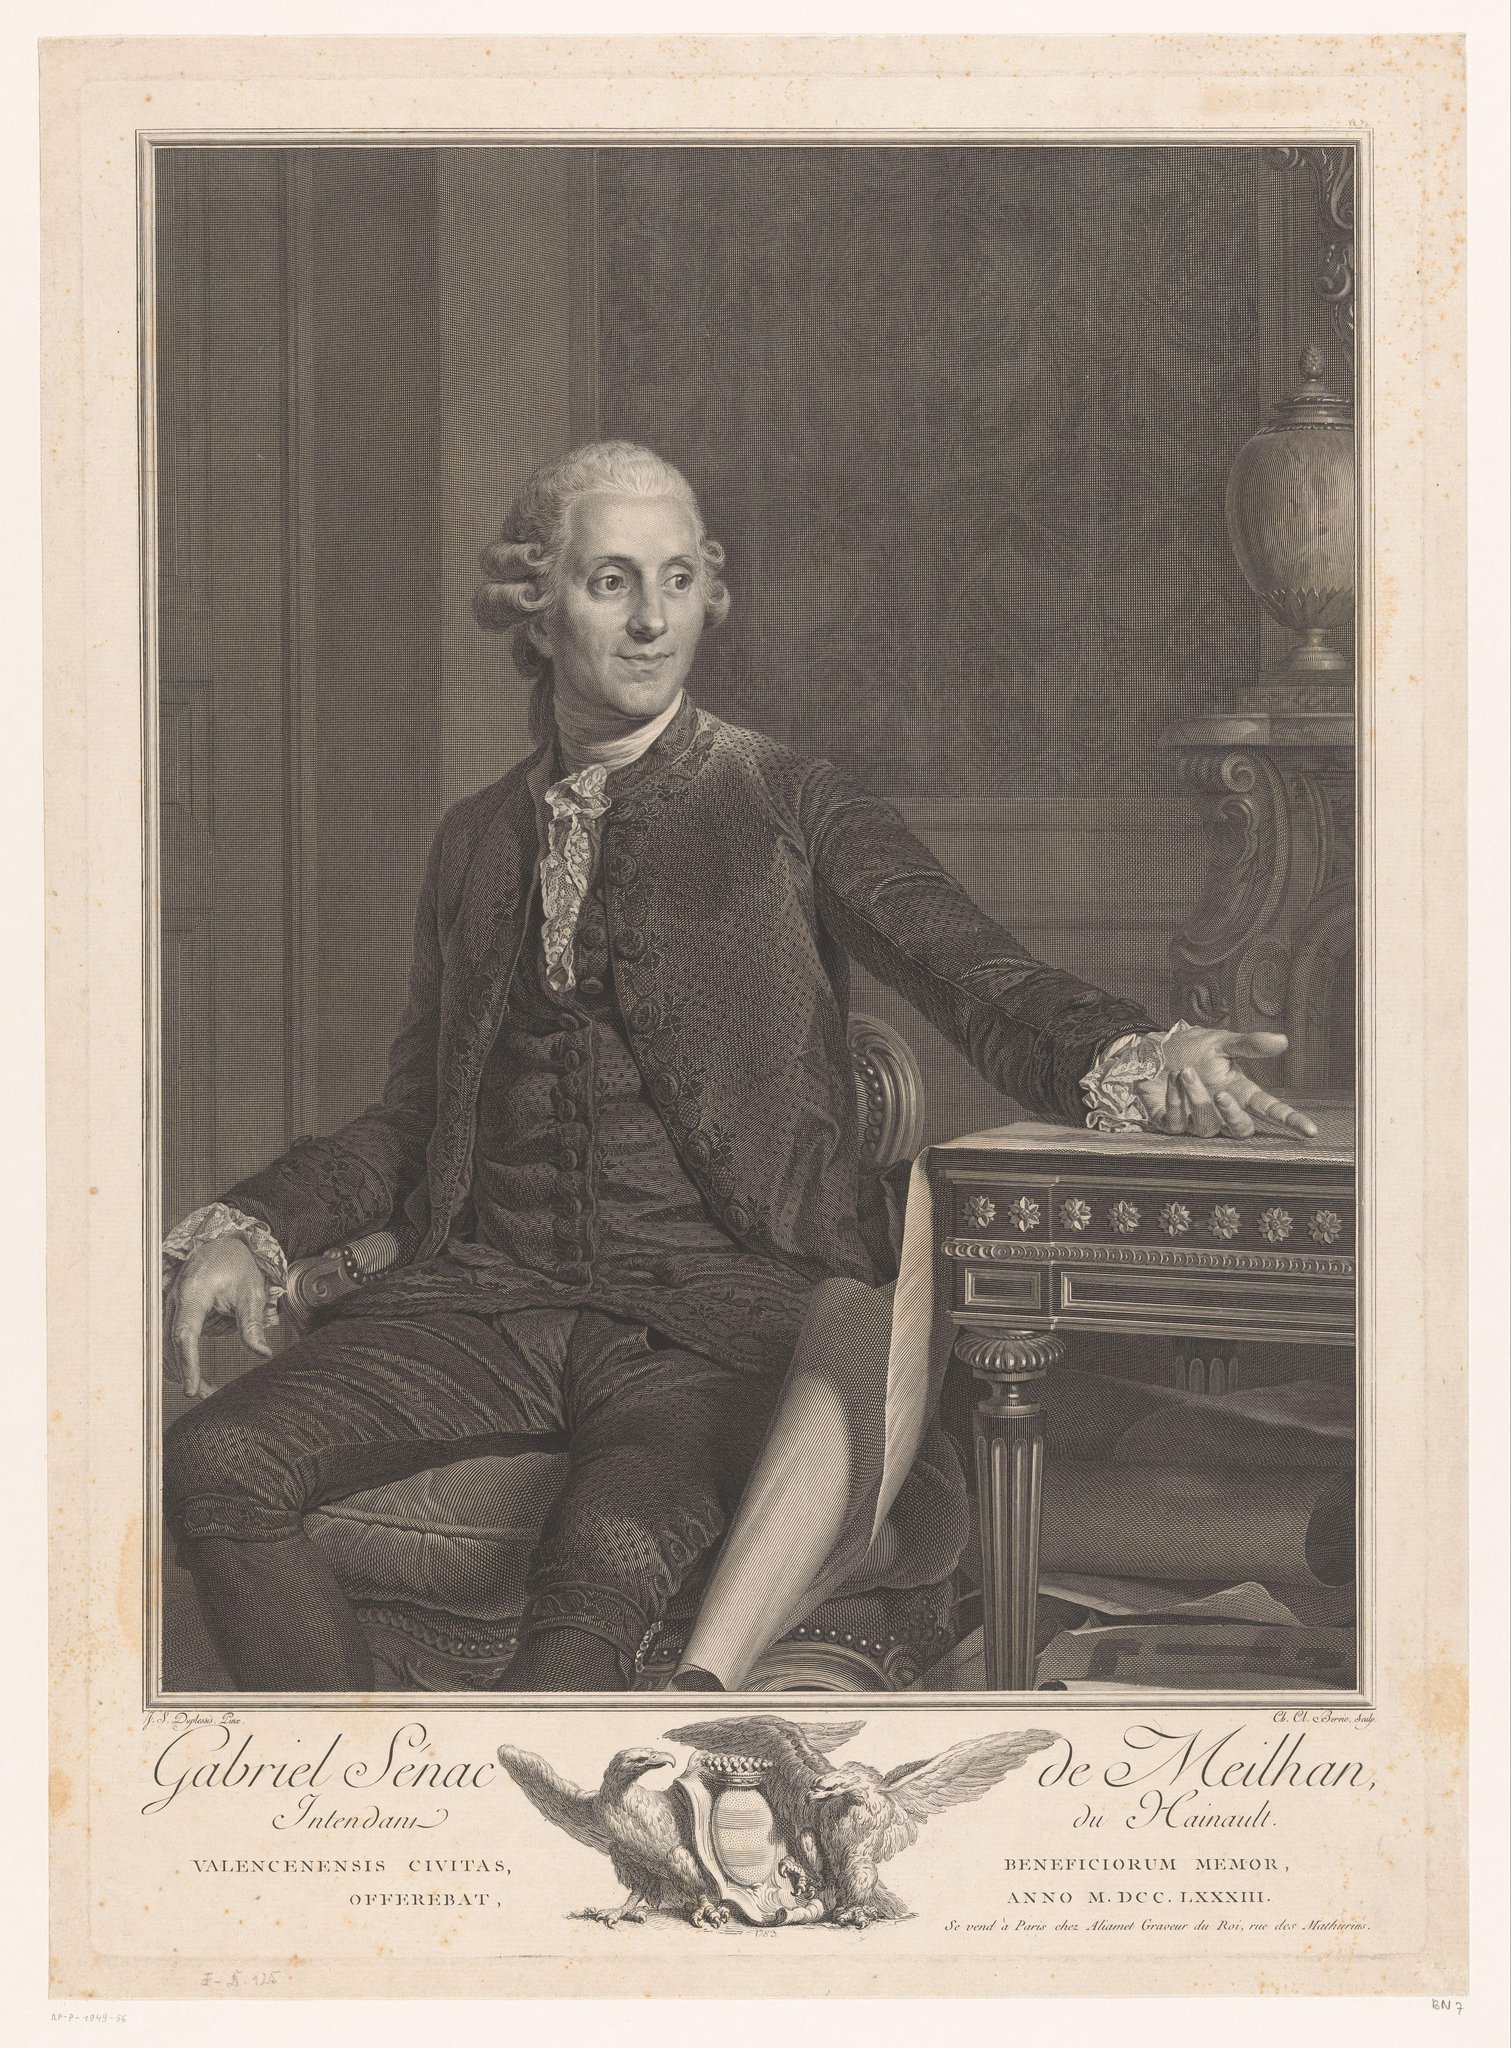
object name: print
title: Gabriel Sénac de Meilhan, Intendant du Hainault.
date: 1783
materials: paper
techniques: engraving, etching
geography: france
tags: sitting with legs bent, side by side, historical persons, armorial bearing, heraldry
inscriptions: collector's mark: Lugt 2477, collector's mark: Lugt 2228